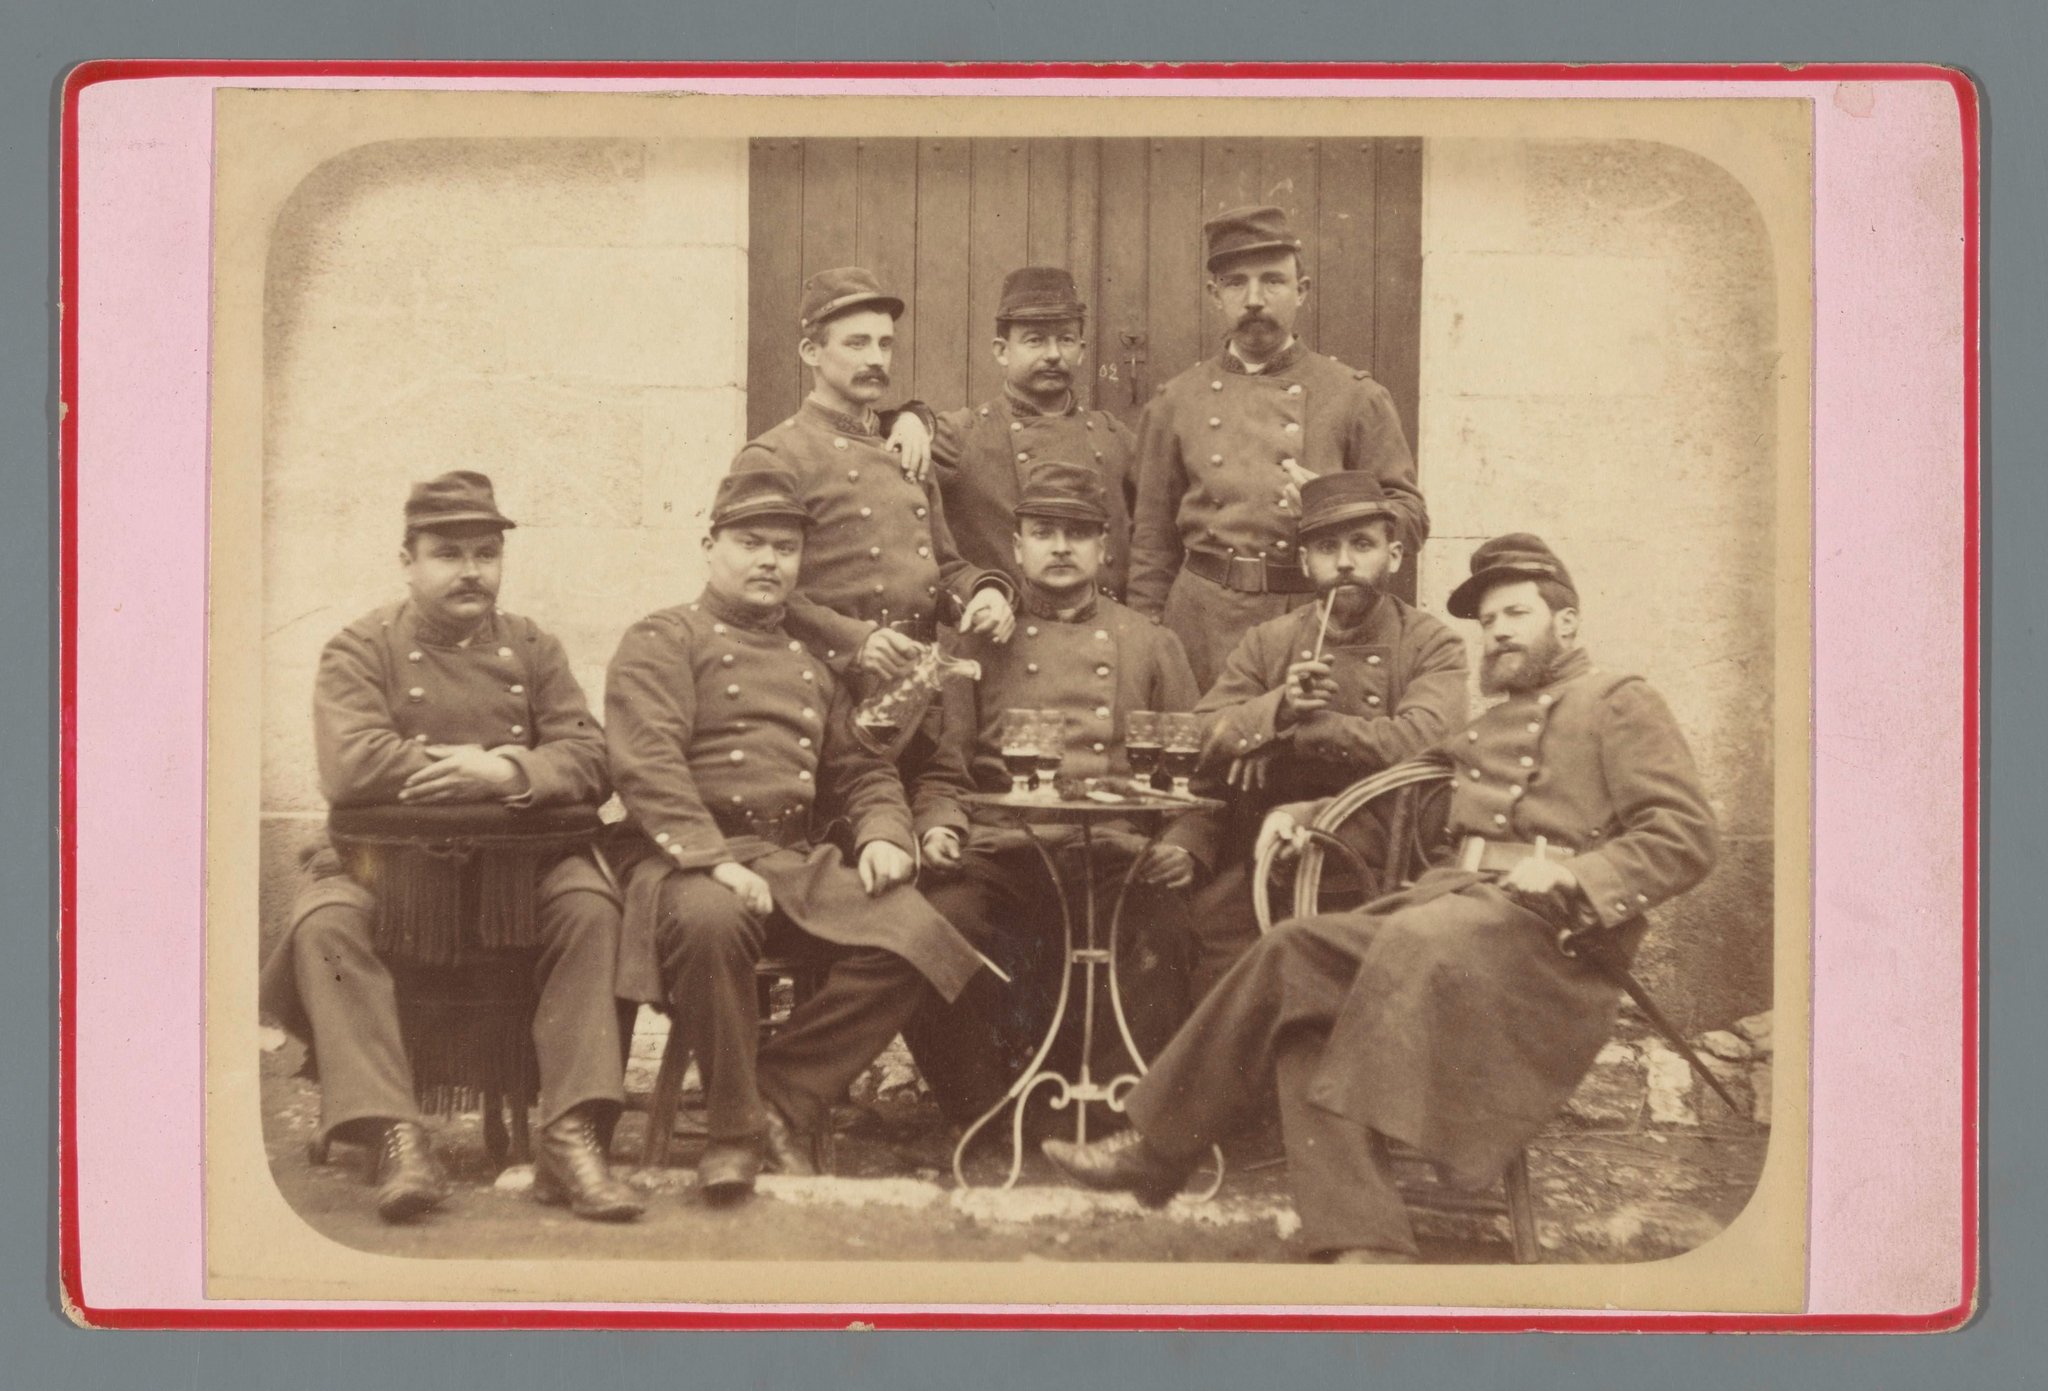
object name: cabinet photograph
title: Groepsportret van zittende militairen die wijn drinken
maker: Anonymous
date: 1870-1890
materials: cardboard, photographic support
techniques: albumen print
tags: private soldier, weapons, head-gear: cap, (military) uniforms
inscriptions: stamp: ‘Collection M. Catto’